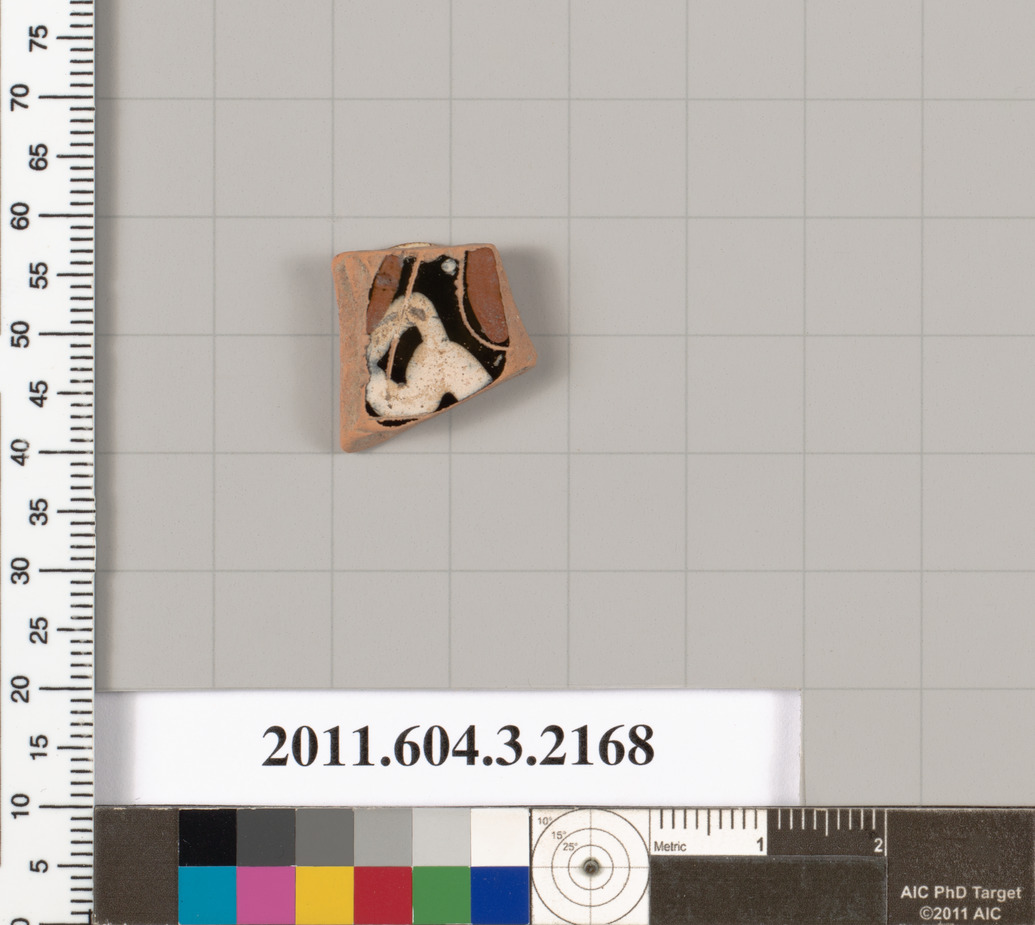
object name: kylix fragment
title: Terracotta fragment of a kylix (drinking cup)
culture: greek, attic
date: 534-501 BCE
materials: terracotta